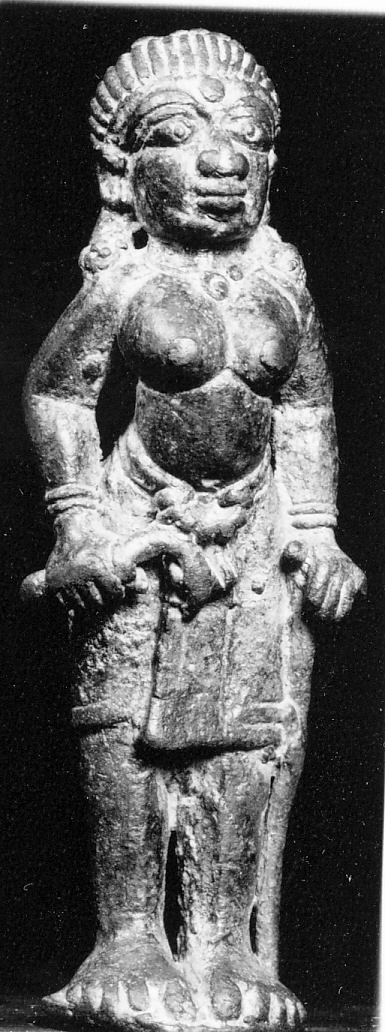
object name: figure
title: Standing Woman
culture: indonesian, javanese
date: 1101-1400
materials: bronze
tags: women